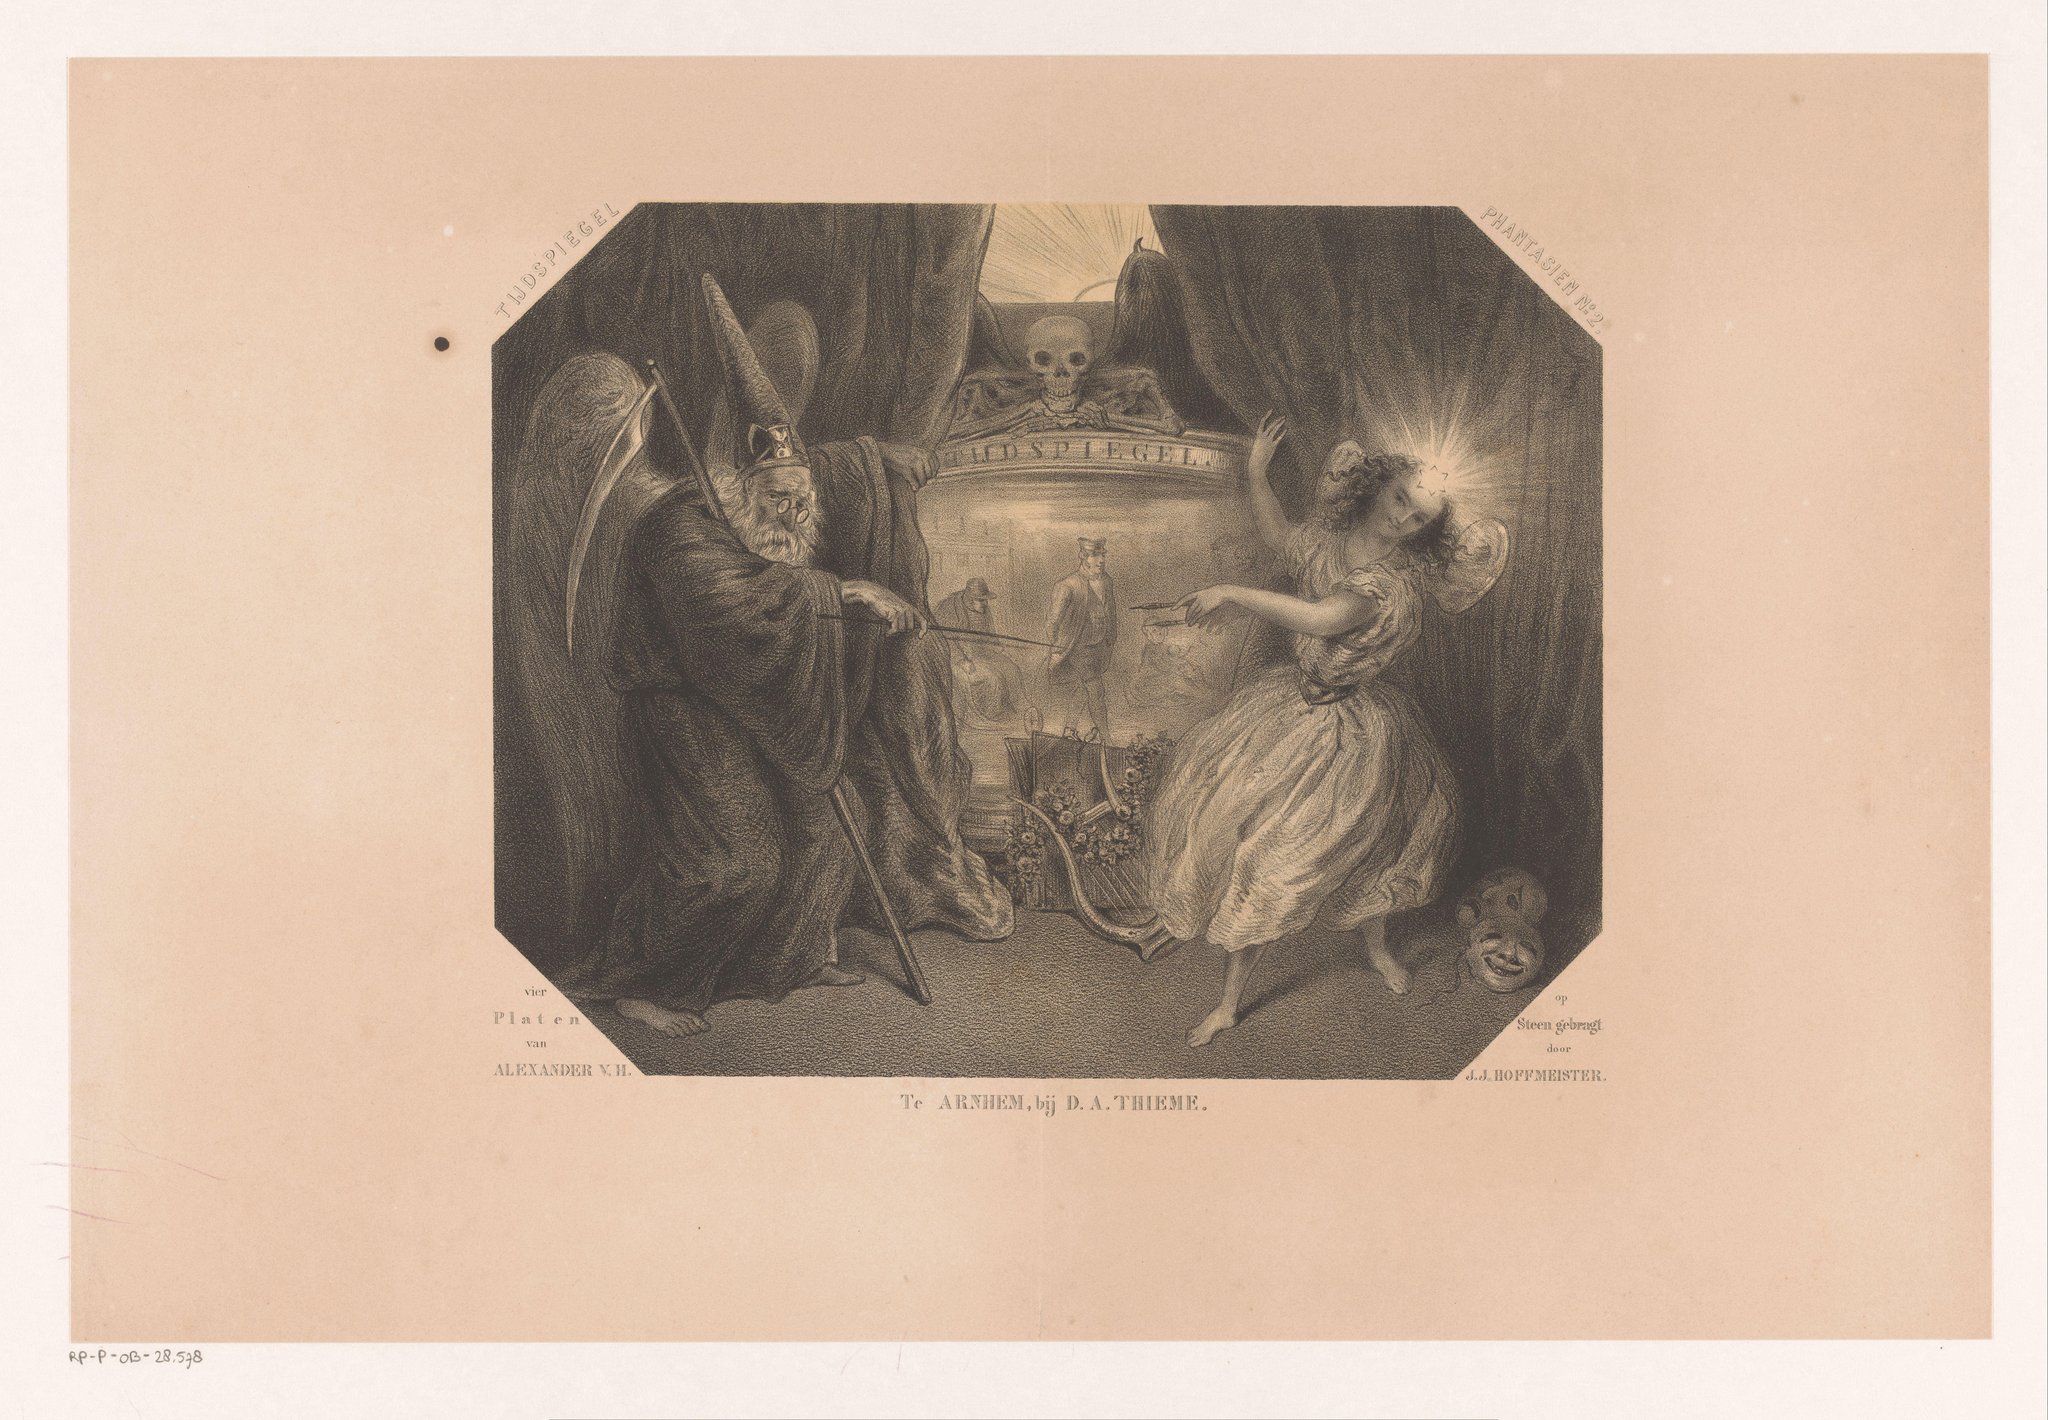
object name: titelprent, frontispice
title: Tydspiegel-phantasien No. 2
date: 1858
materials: paper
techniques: lithograph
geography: arnhem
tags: symbolic representations, allegories and emblems ~ the theatre, mirror, death as skeleton, harp, father time, man with wings and scythe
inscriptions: collector's mark: Lugt 2228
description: Links en rechts van een spiegel staan een man met een lange baard en een meisje. De man heeft vleugels, draagt een puntmuts met een zandloper en heeft een zeis in zijn armen. Het meisje heeft een ster op het voorhoofd en vleugels op haar rug. Zij wijzen naar een scène die zich afpeelt in de spiegel: een voorstelling die is opgenomen in deze uitgave getiteld 'Eigendom en genot'. Boven de spiegel de dood in de vorm van een gevleugeld skelet. Op de grond liggen een harp, bloemen en maskers.